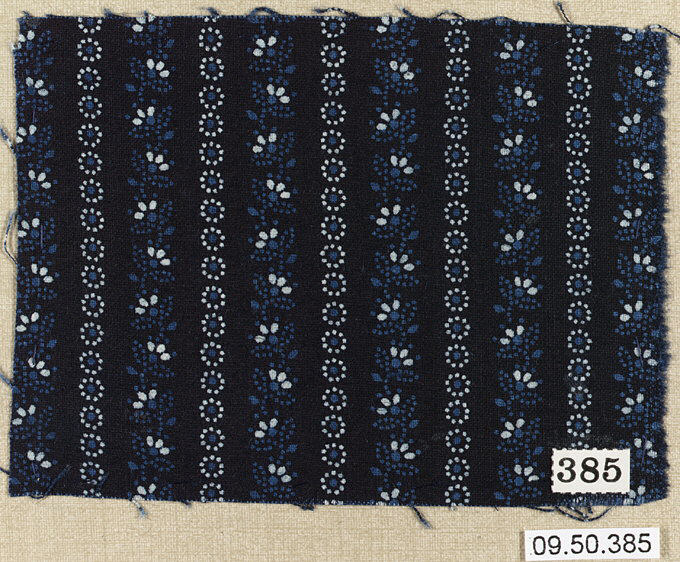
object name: piece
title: Piece (one of 116)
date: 1801-1900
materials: cotton